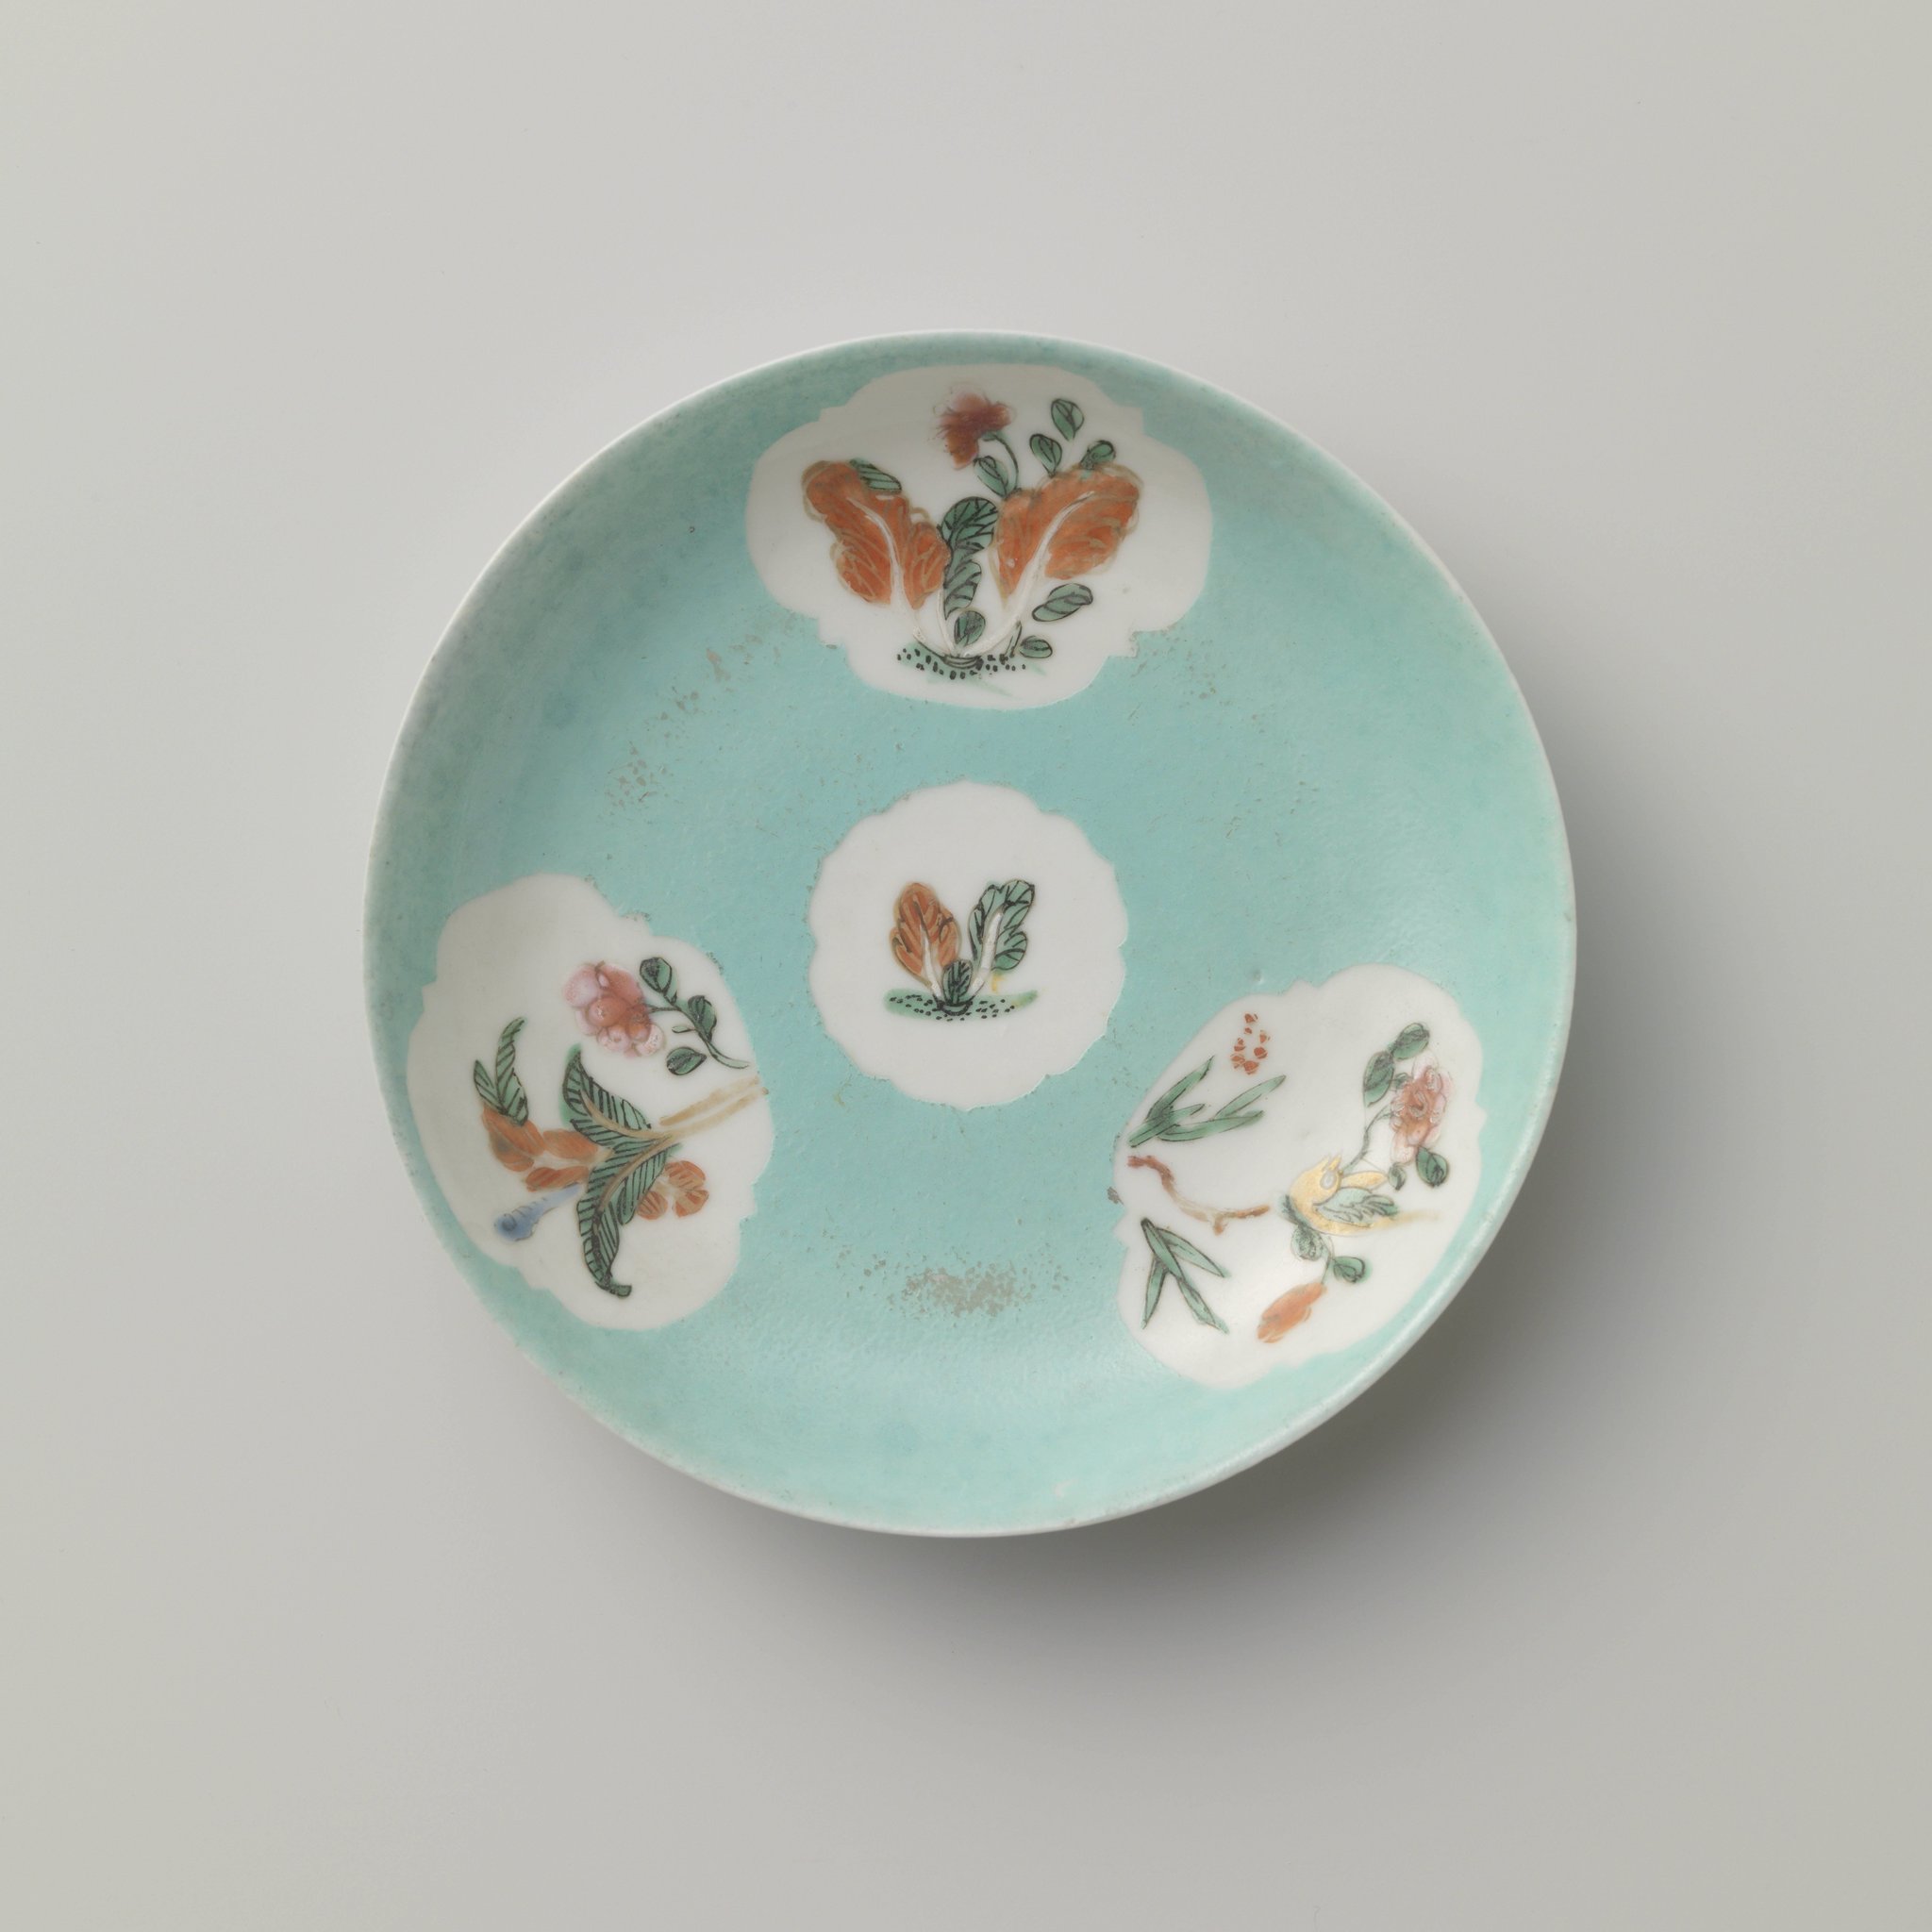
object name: platter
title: Saucer with flowering plants in shaped panels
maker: Anonymous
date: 1760-1780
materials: glaze, gold, paint, porcelain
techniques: firing, gilding, turning, vitrification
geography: china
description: Schotel van porselein, bedekt met een turquoise glazuur en berschilderd in blauw, rood, roze, groen, zwart en goud. De schotel is aan de voorzijde bedekt met een turquoise glazuur met hierin uitgespaard in het centrum een geschulpt medaillon met plant, daaromheen drie uitgespaarde cartouches met bloeiende planten en een vogel op een tak. Famille rose.